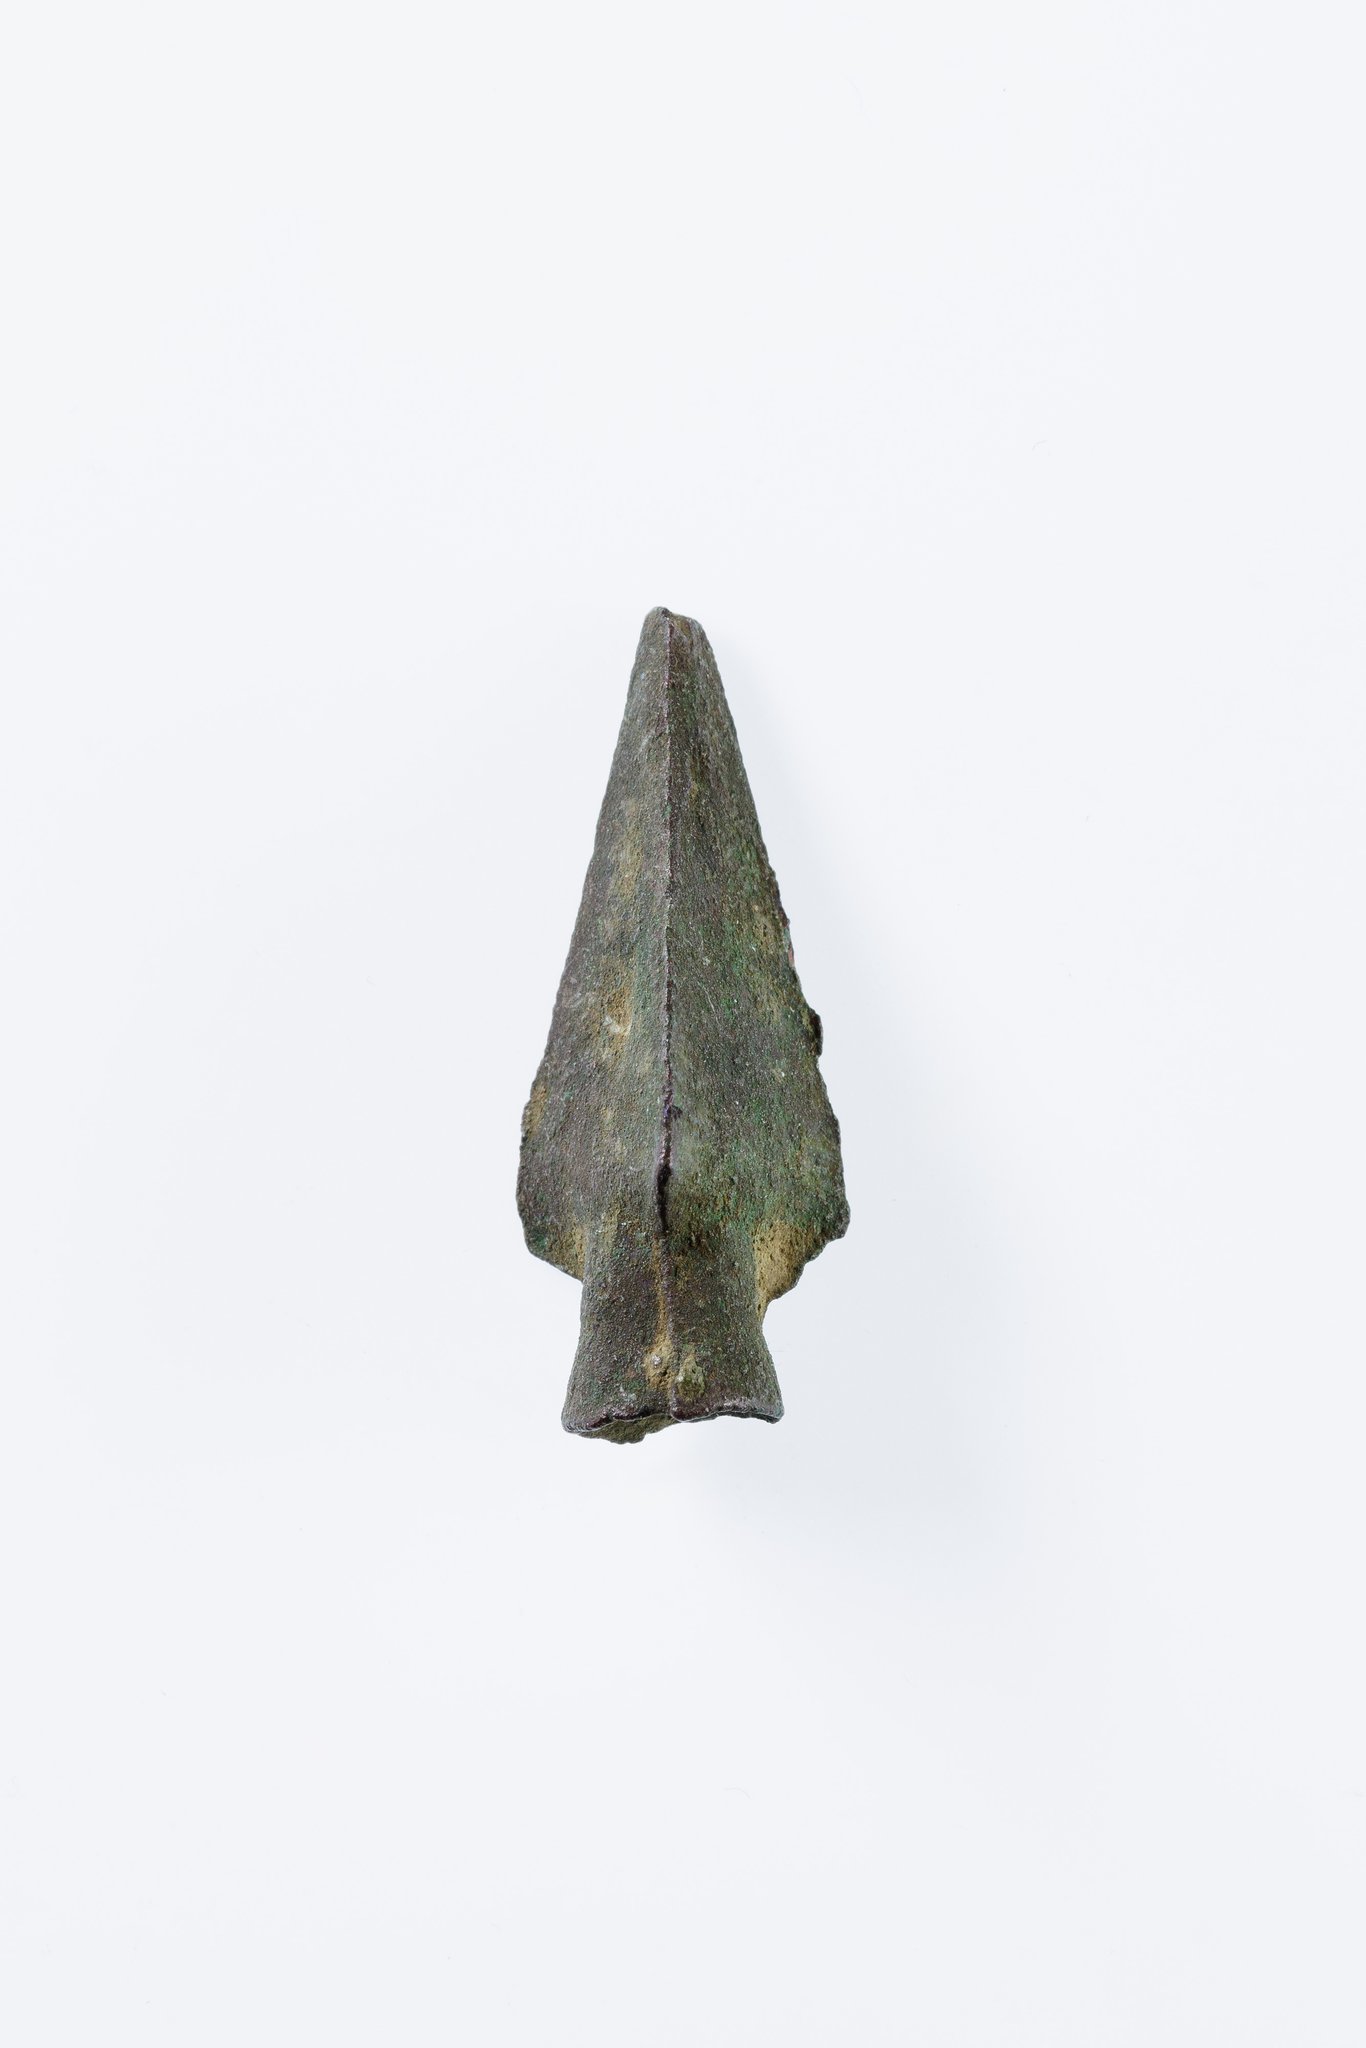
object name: arrow point, apries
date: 589-570 BCE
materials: bronze, copper alloy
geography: egypt